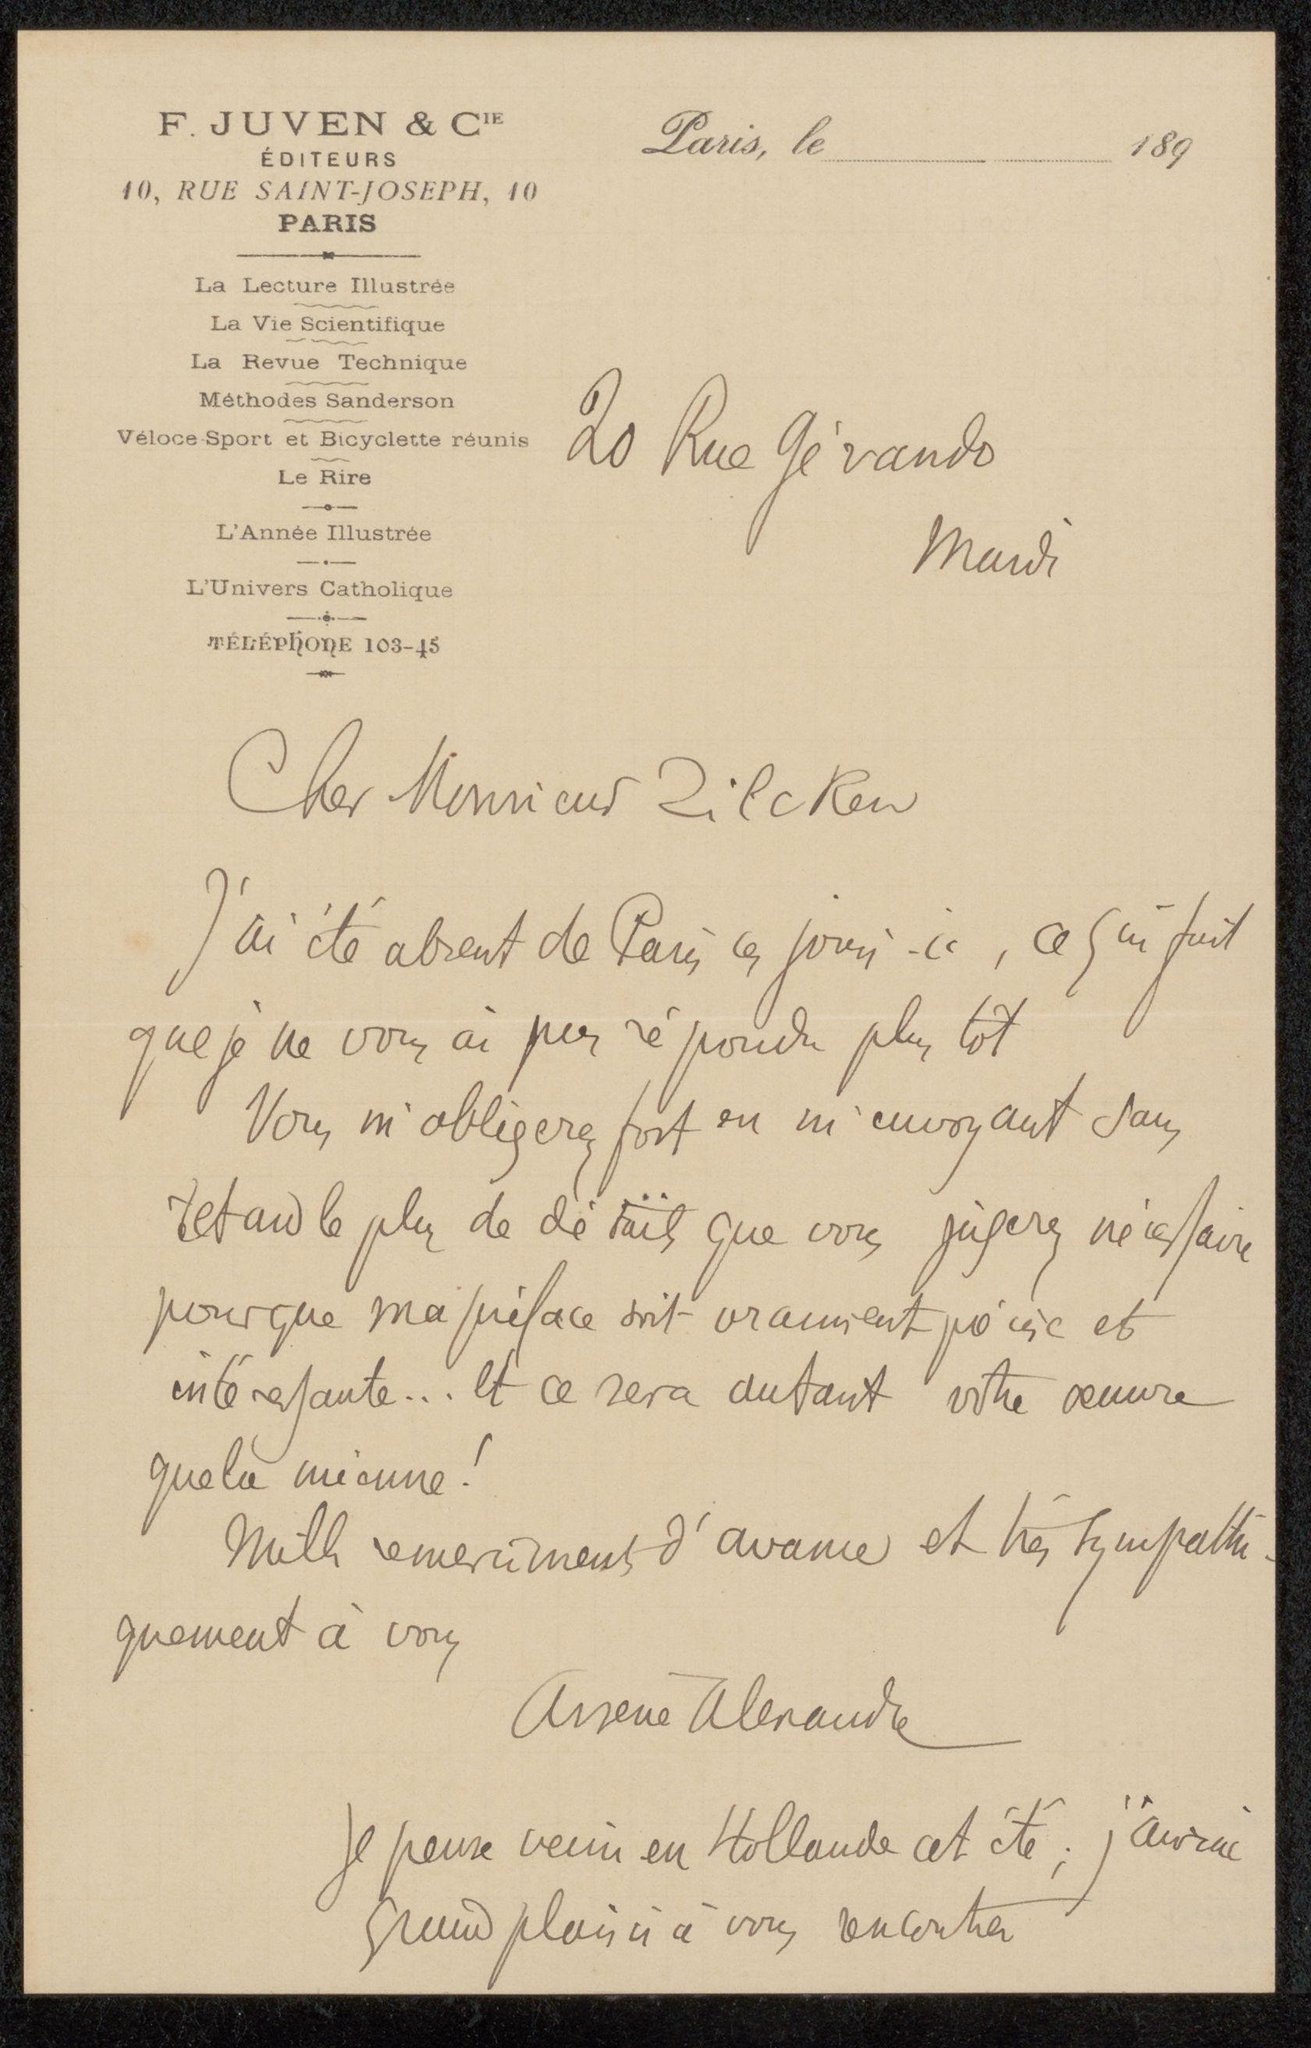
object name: letter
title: Brief aan Philip Zilcken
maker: arsène alexandre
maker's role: auteur, verzamelaar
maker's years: 1859-1937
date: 1897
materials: ink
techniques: pen, printing, writing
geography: paris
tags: painter, draughtsman, philip zilcken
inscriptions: collector's mark: ‘RPK’